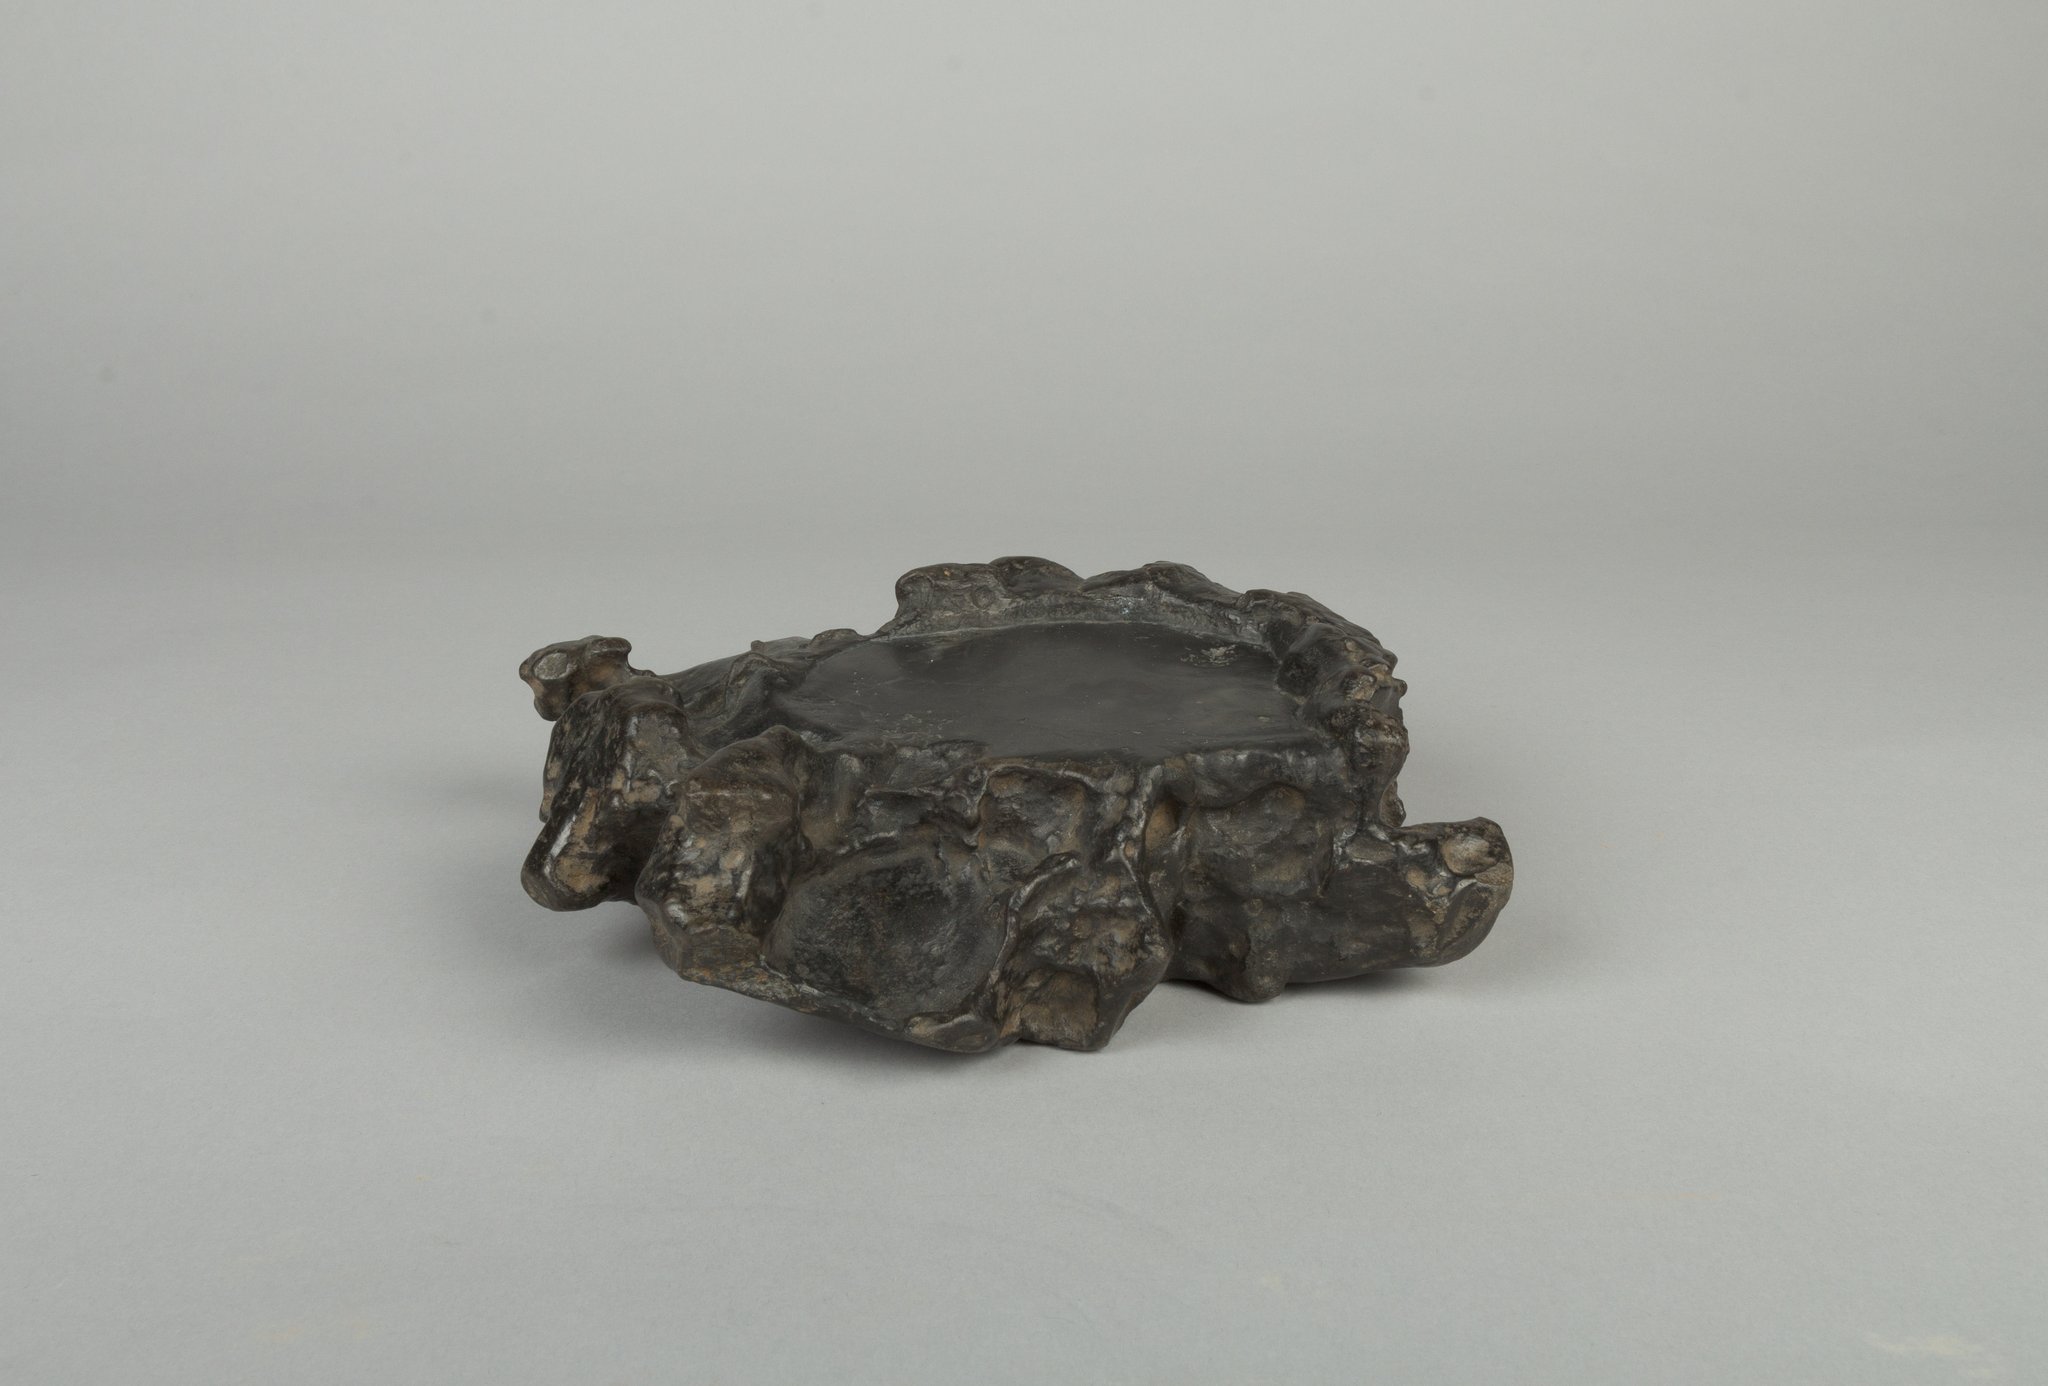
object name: inkstone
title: Inkstone with Knobbed Protrusions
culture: chinese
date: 1644-1911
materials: limestone